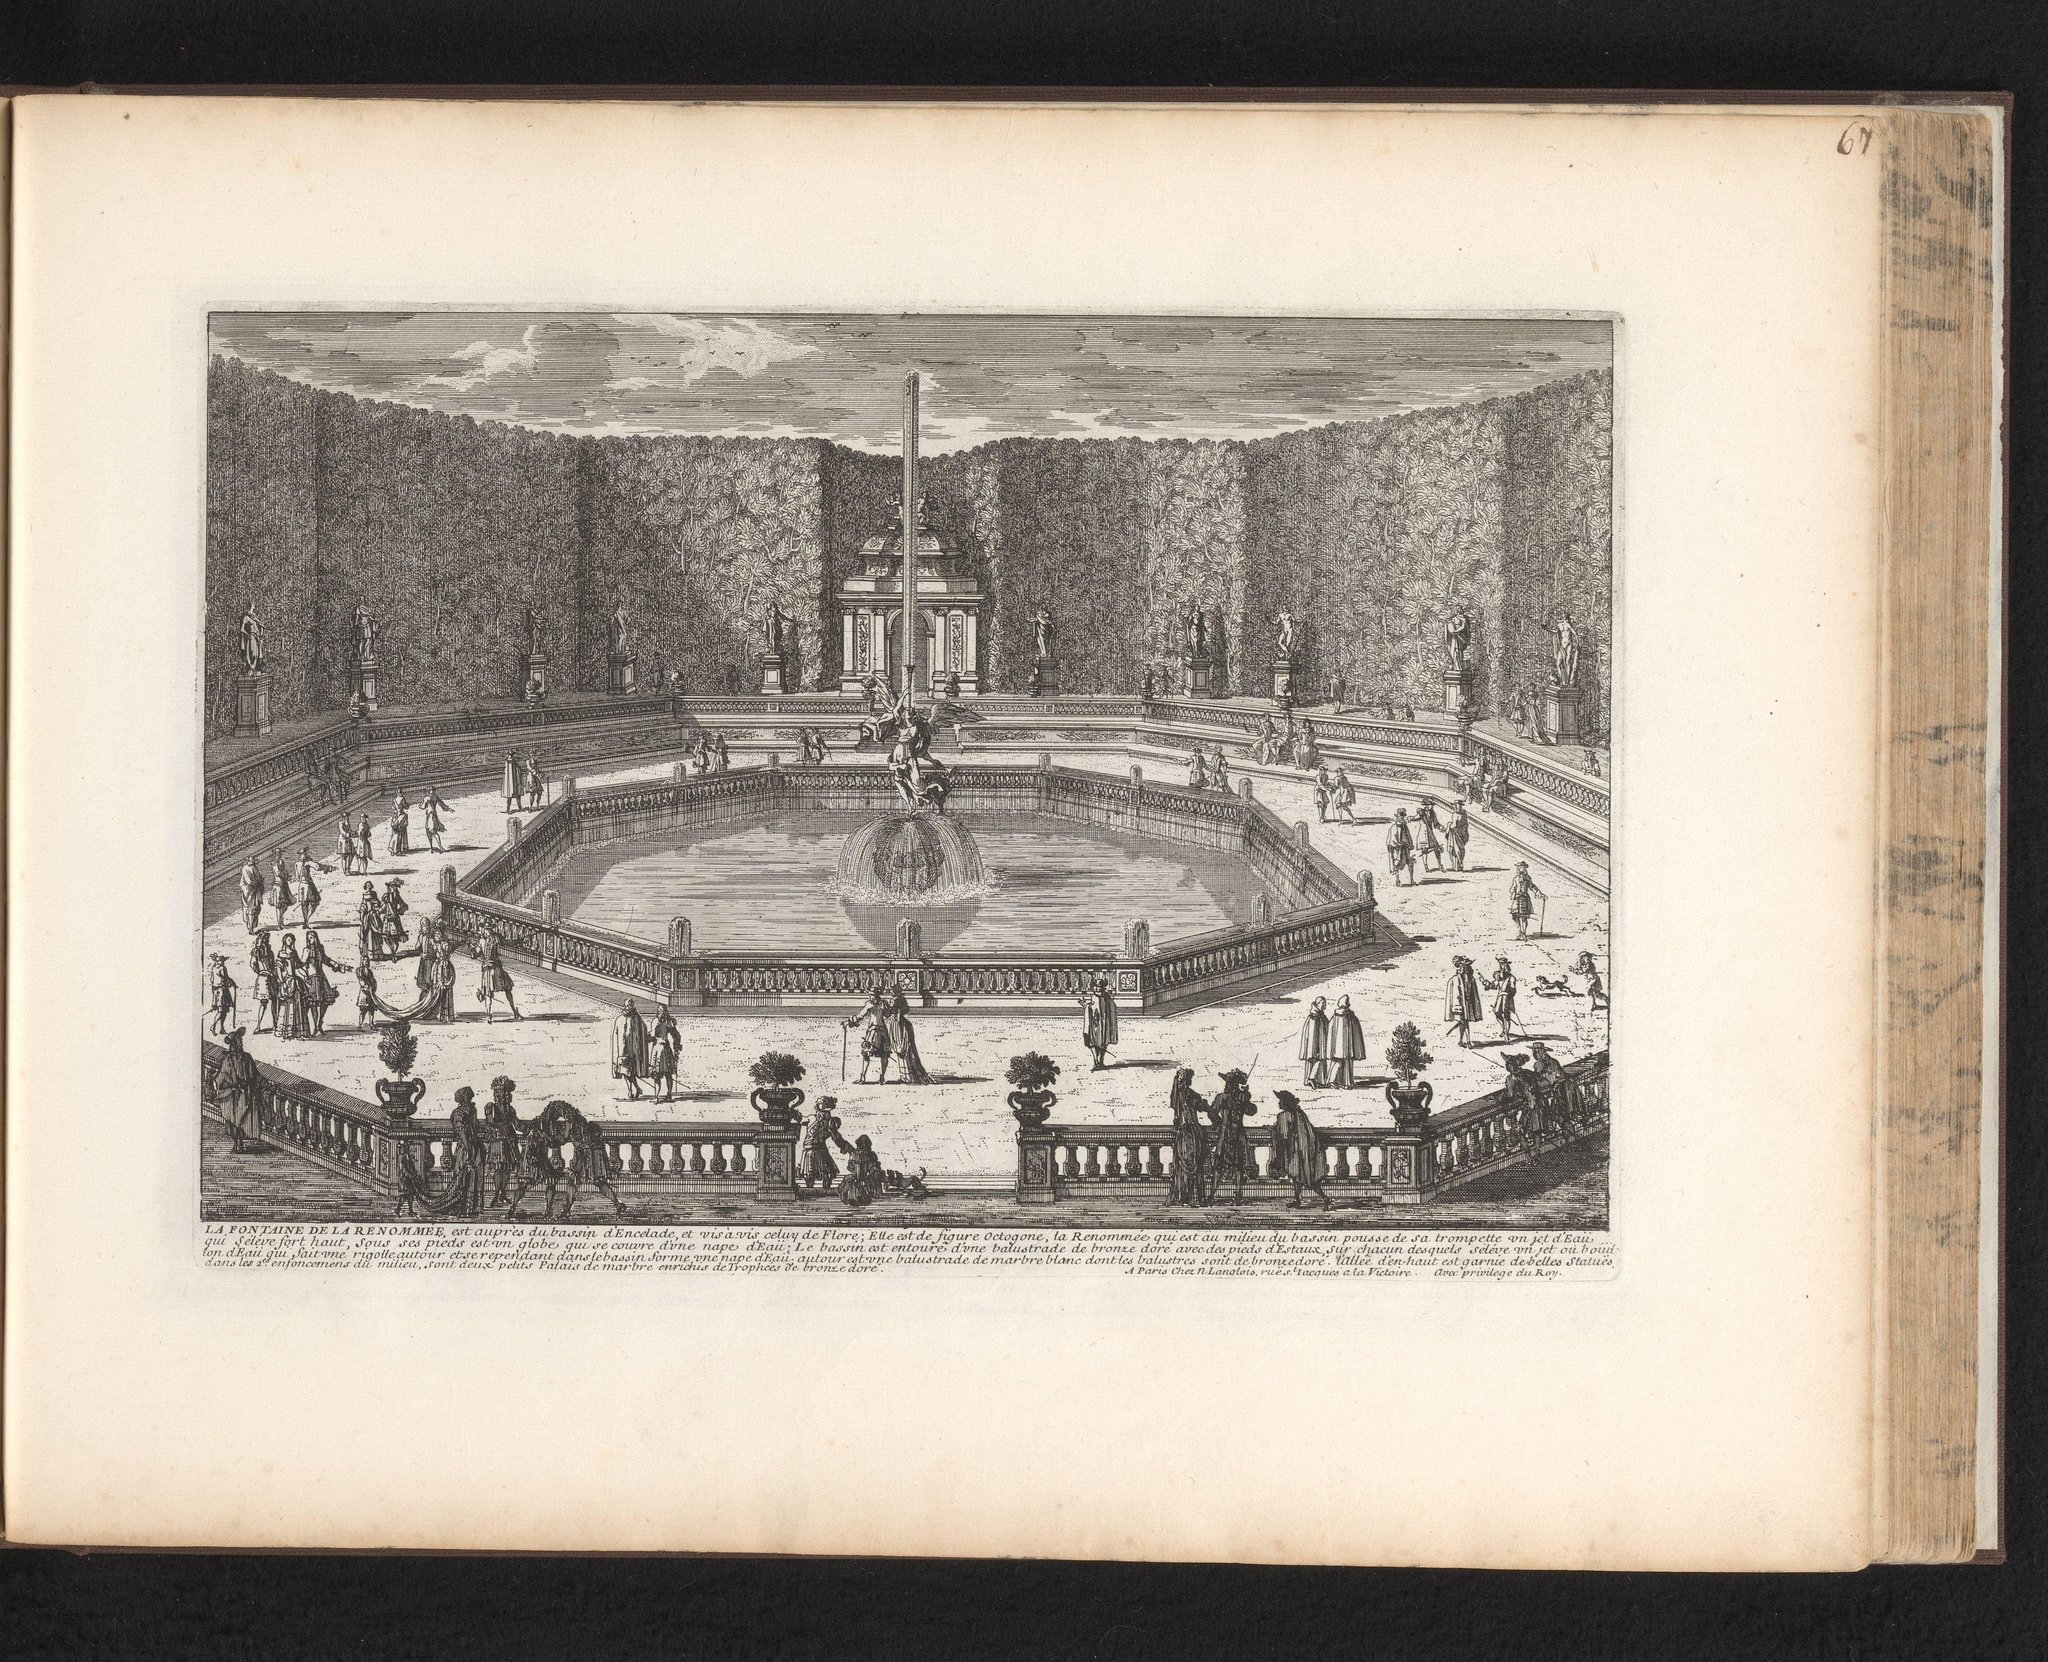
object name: print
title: Recueil de vues de monuments de Paris, des principales résidences royales et des principaux châteaux de France et de Rome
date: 1664-1703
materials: paper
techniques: etching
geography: france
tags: garden fountain, french or architectonic garden; formal garden, fame; 'fama', 'fama buona', 'fama chiara' (ripa)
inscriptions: collector's mark: Lugt 2228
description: Prenten met het signatuur 'Perelle' kunnen zowel door vader Gabriel als door zonen Nicolas en Adam gemaakt zijn. De uitgevers vader en zoon Nicolas Langlois worden allebei vermeld als N. Langlois op hetzelfde adres.